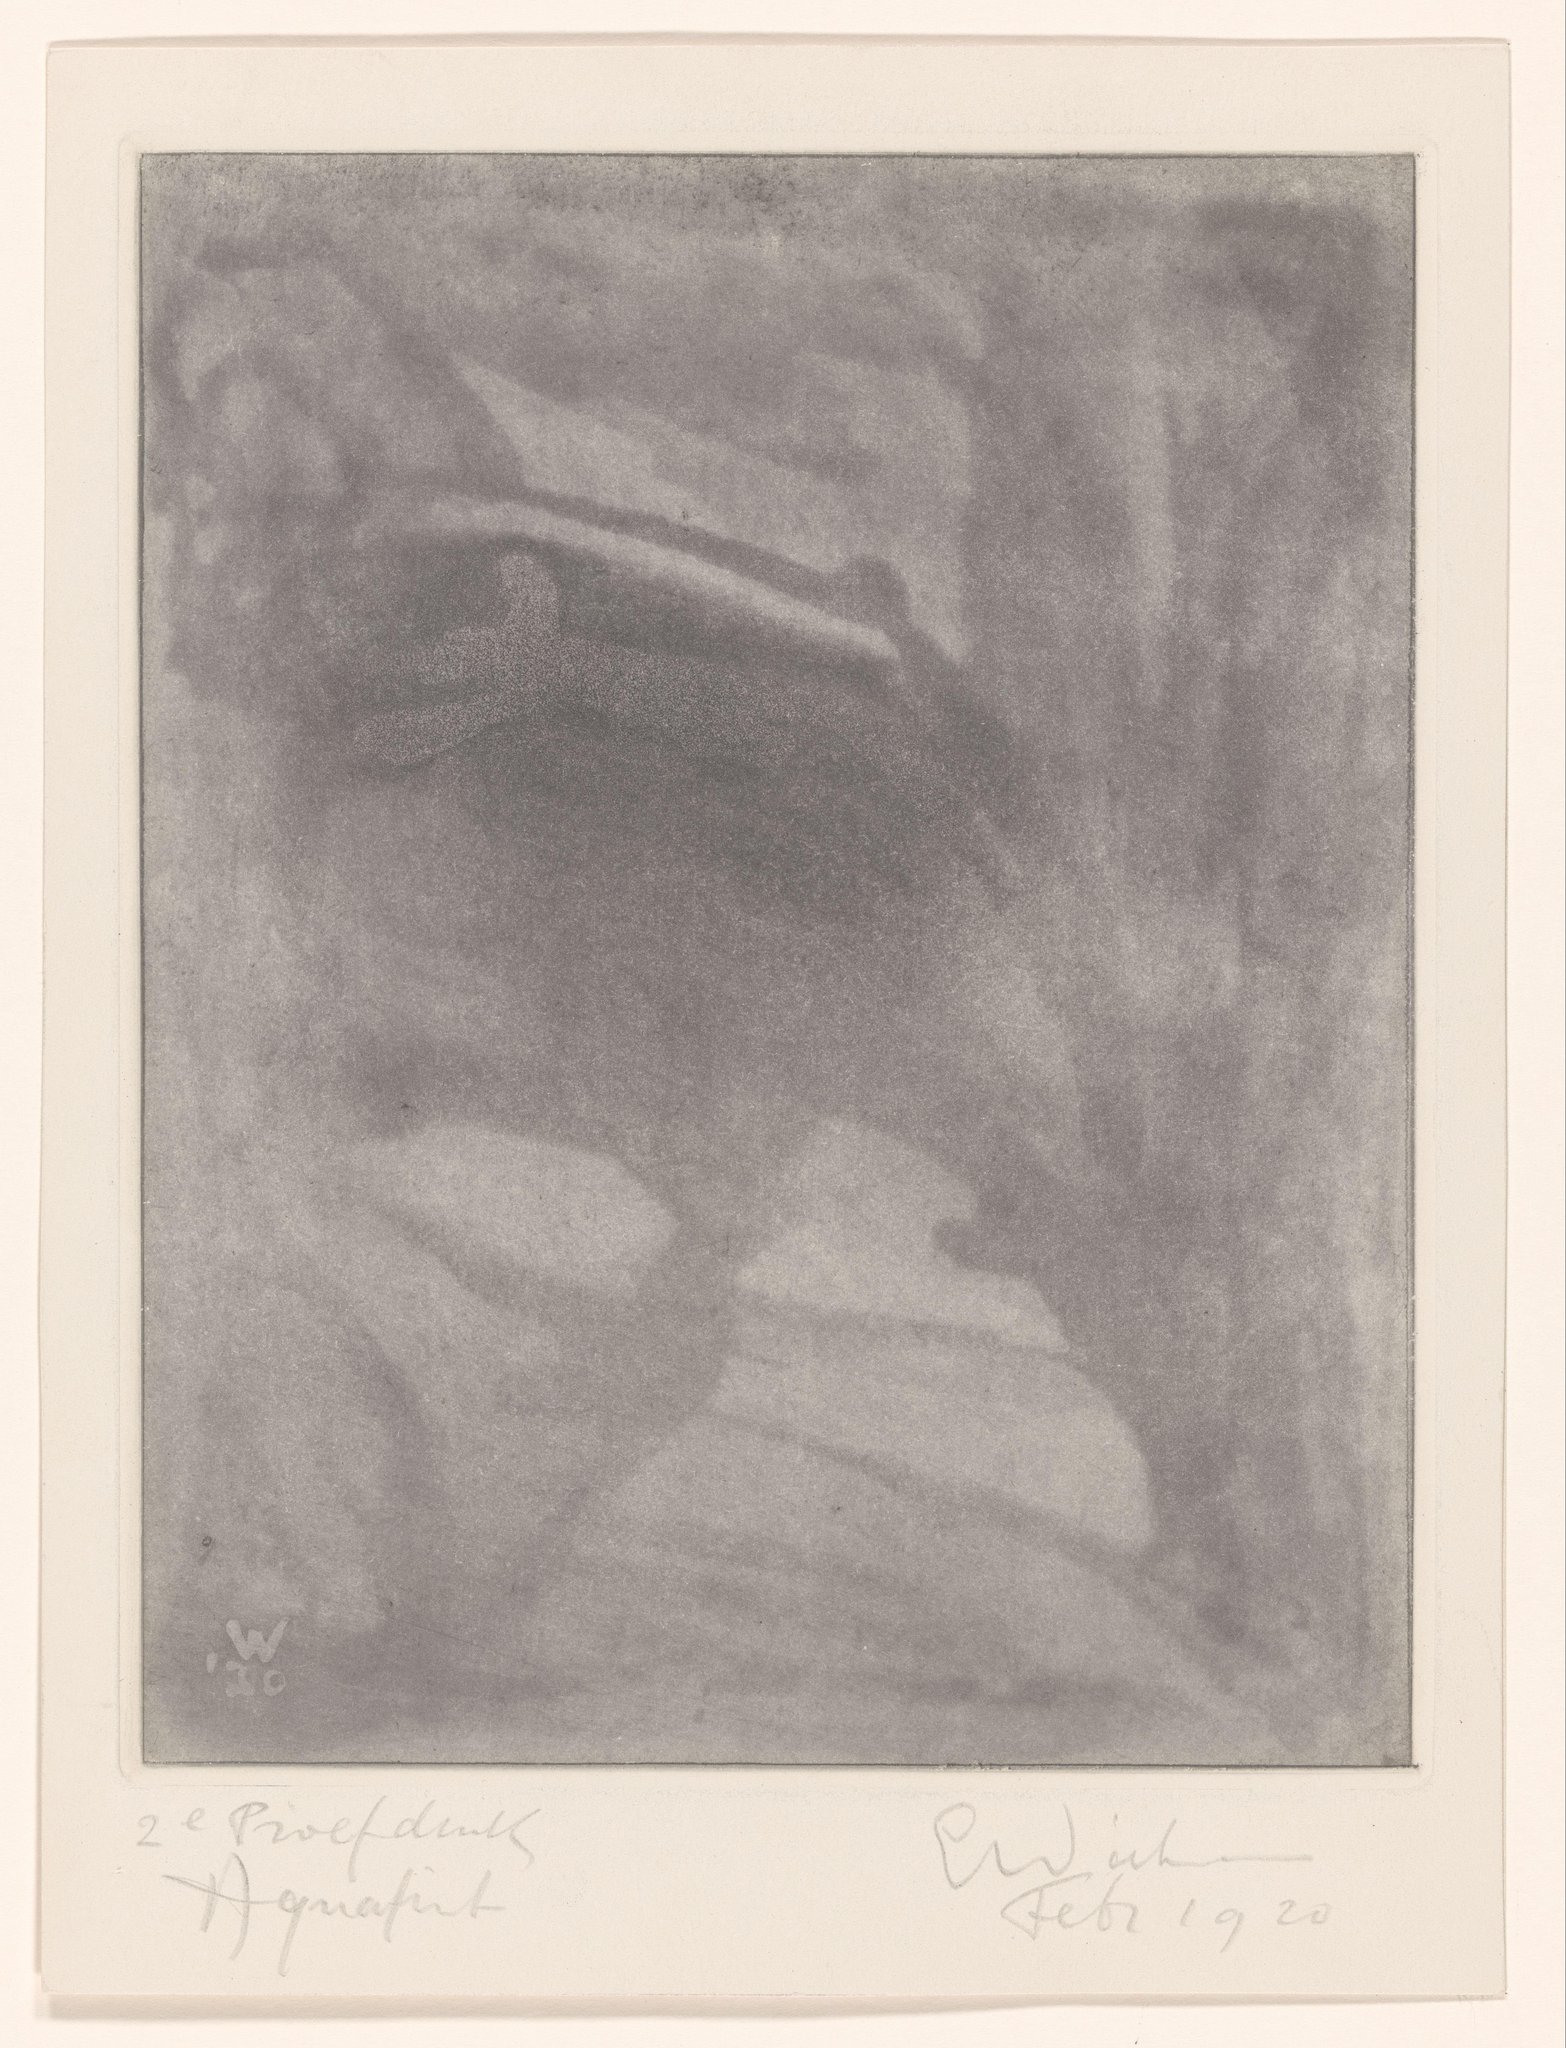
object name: print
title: Abstracte compositie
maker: erich wichmann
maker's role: print maker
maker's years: 1890-1929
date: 1902-1920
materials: paper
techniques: aquatint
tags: abstract, non-representational art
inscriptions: collector's mark: Lugt 2760, collector's mark: Lugt 2228